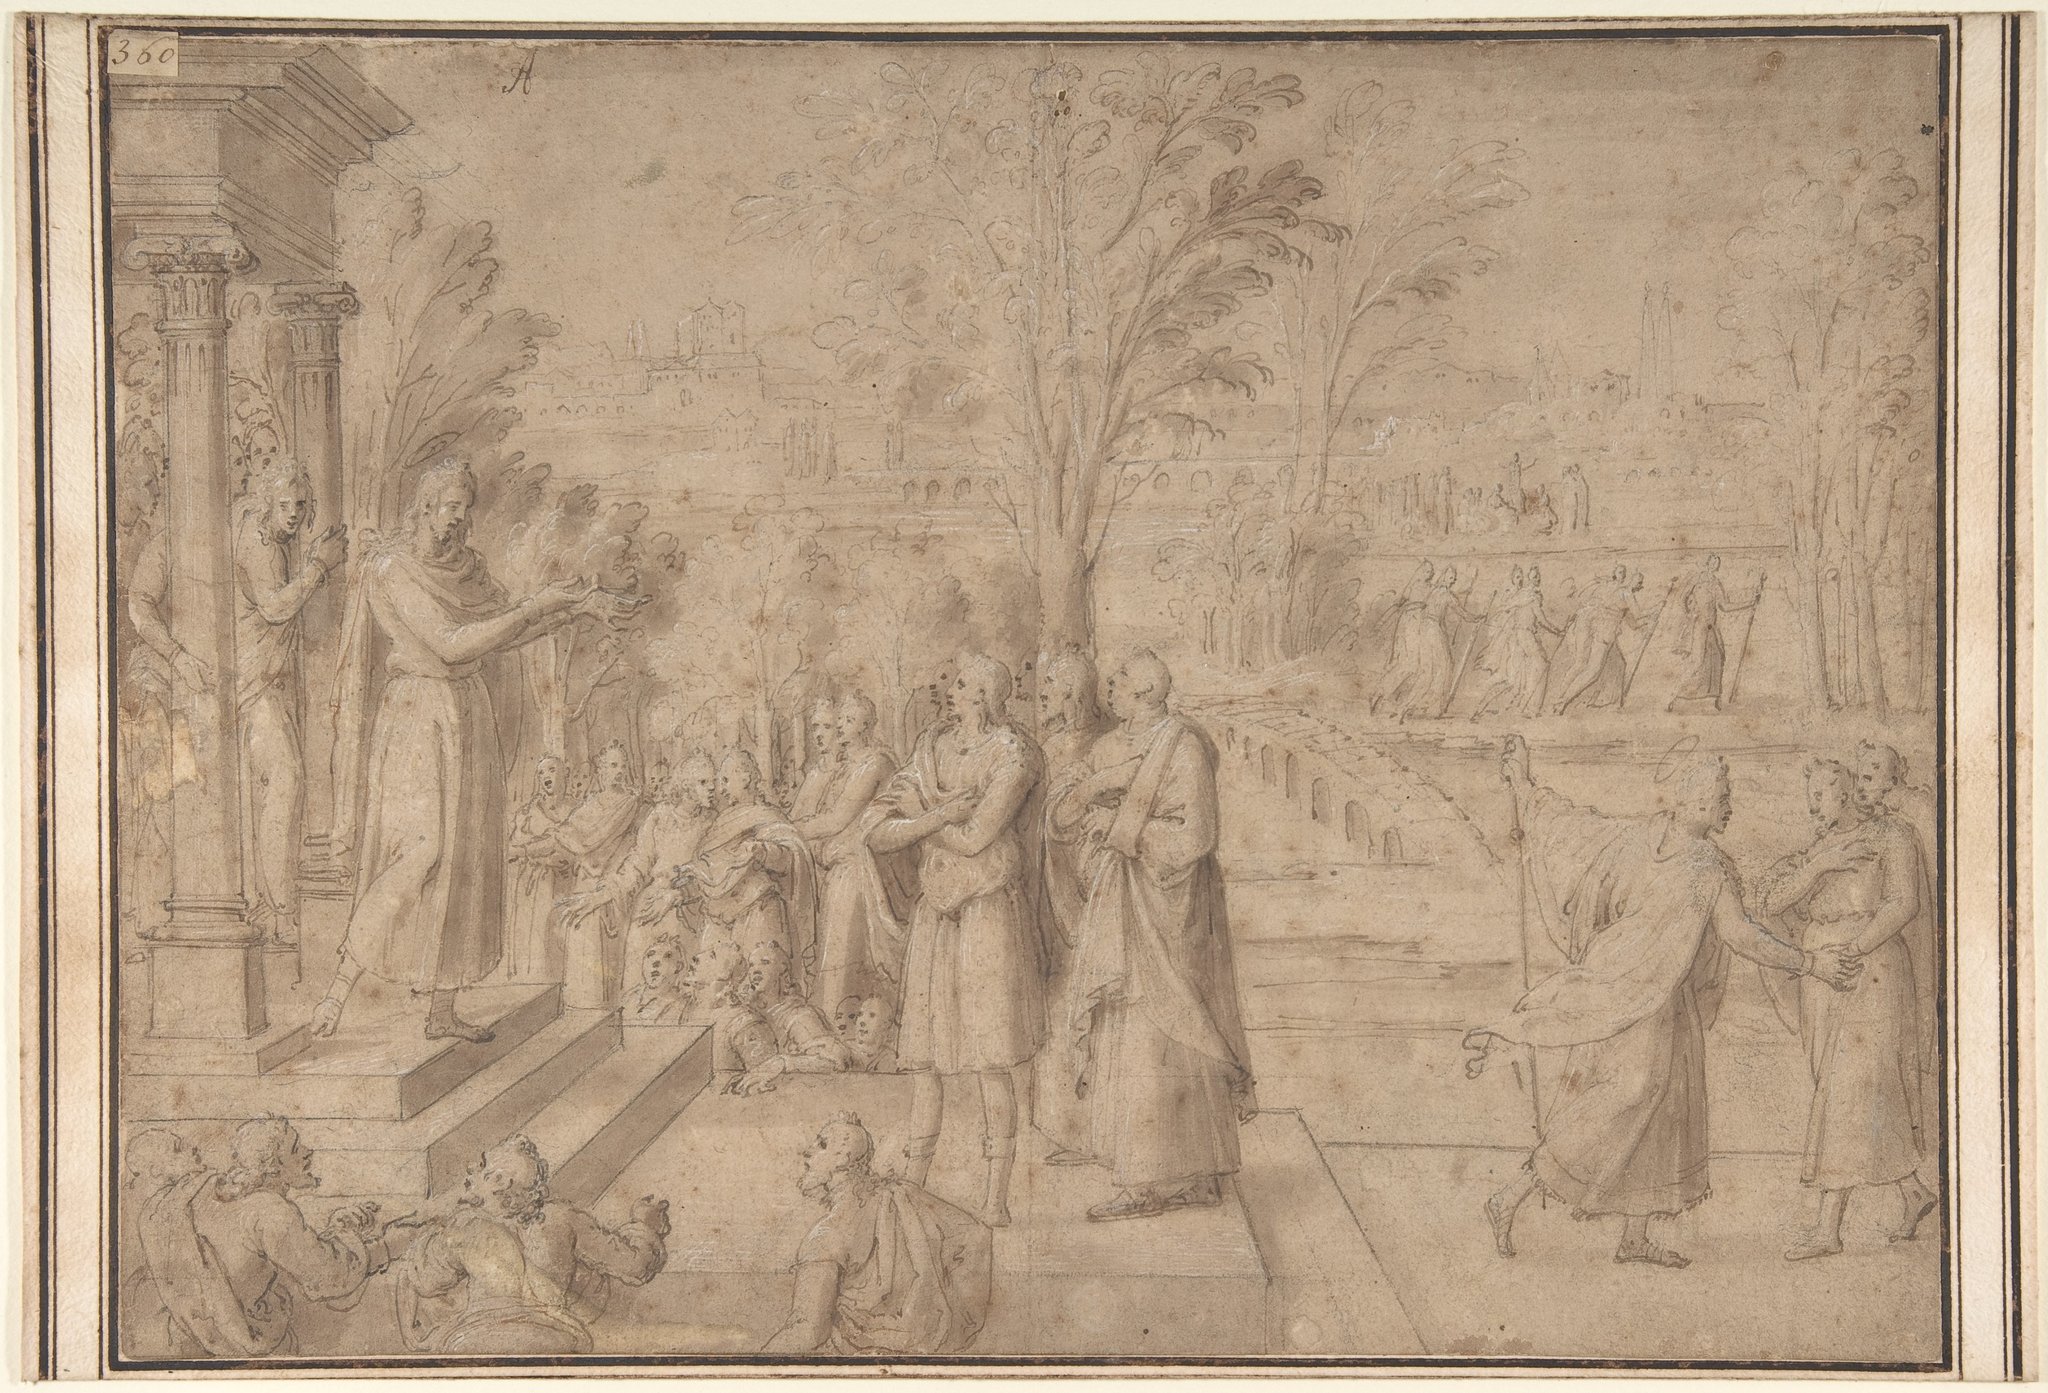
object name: drawing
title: A Saint Addressing Figures from the Steps of a Temple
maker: antoine caron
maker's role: artist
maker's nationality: french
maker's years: 1521-1599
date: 1521-1599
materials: chalk, ink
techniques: brush, heightening, pen, wash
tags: temples,trees,saints,crowd